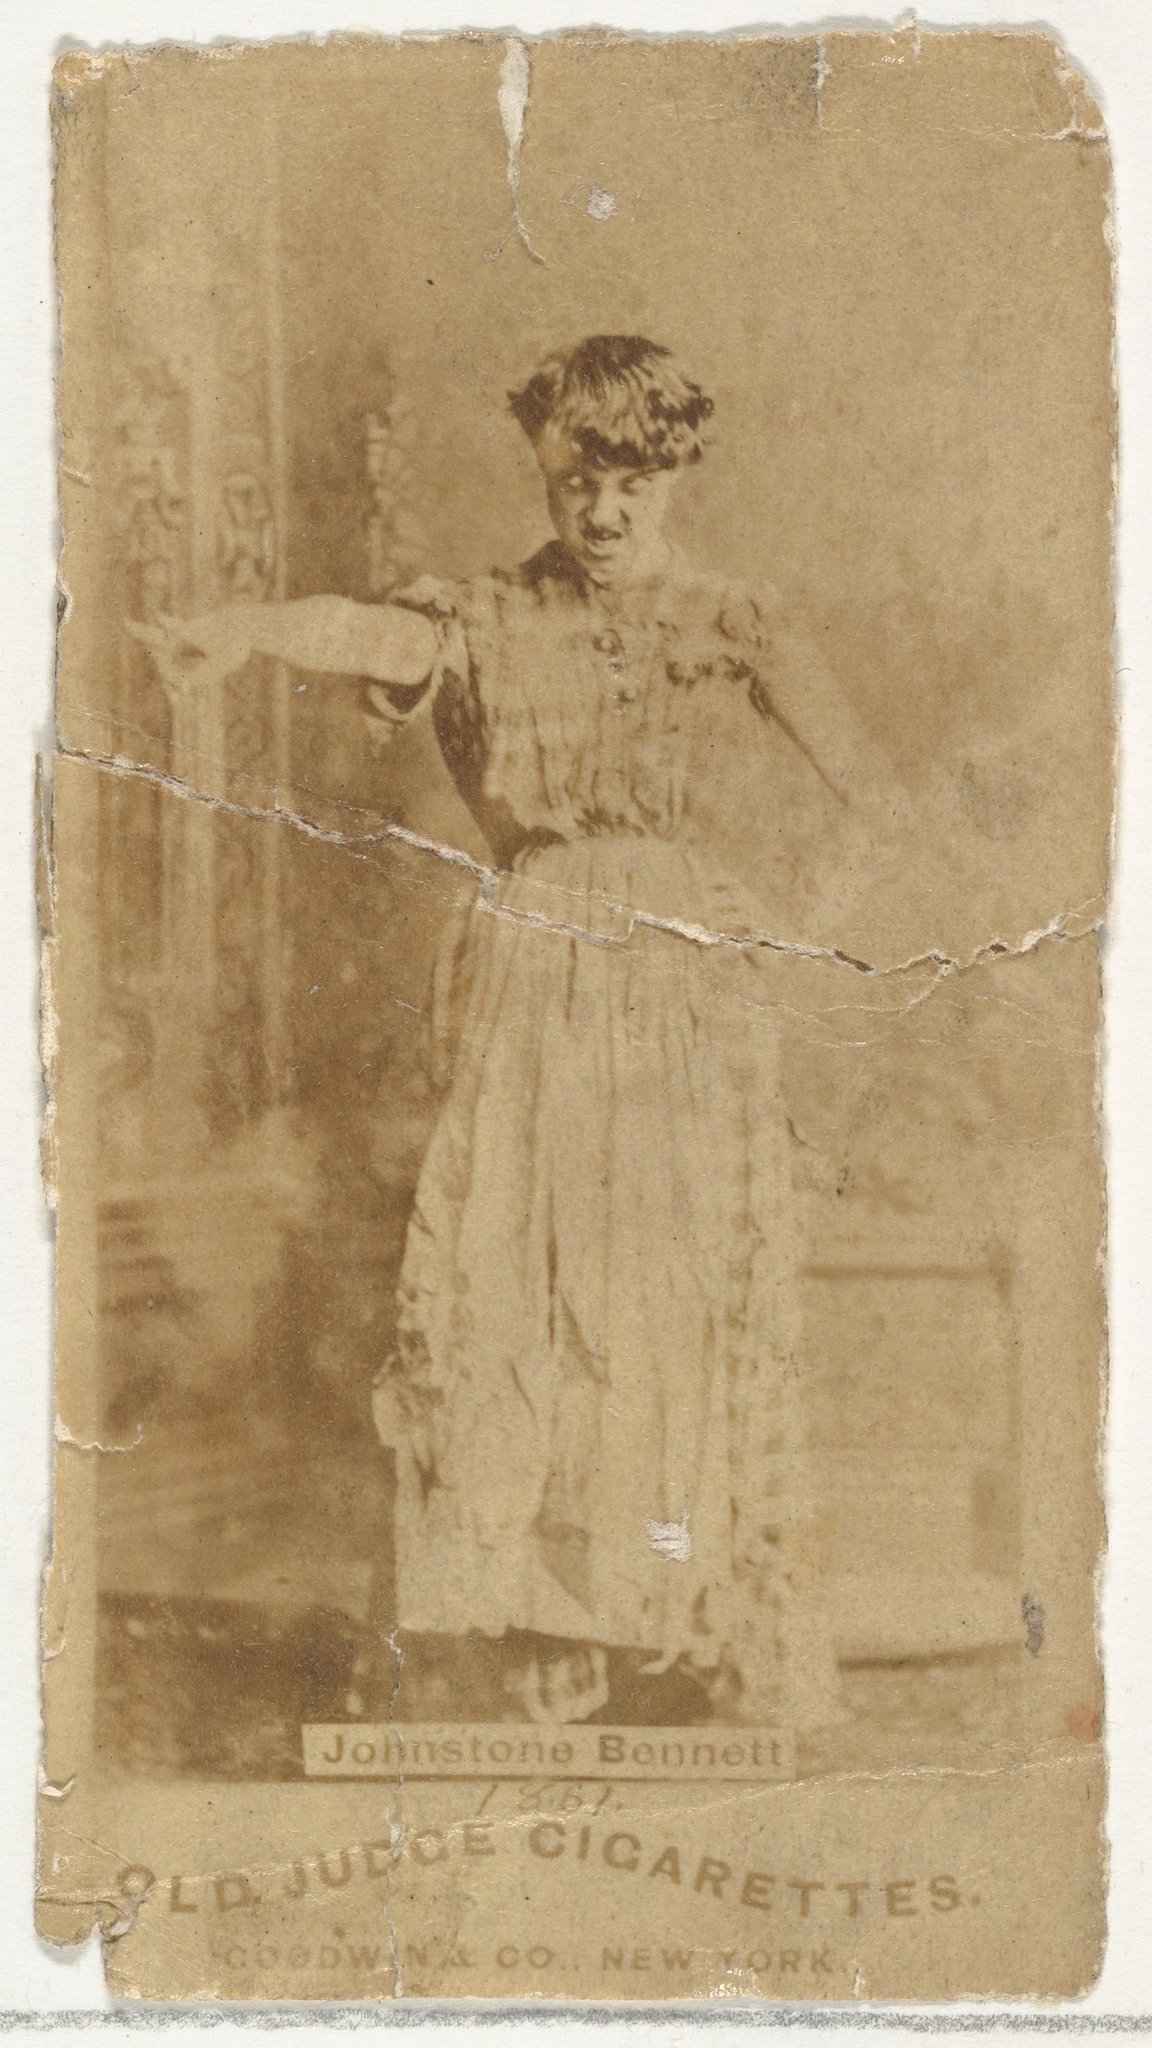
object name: photograph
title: Joanstone Bennett, from the Actors and Actresses series (N171) for Old Judge Cigarettes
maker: goodwin & company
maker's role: publisher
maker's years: 1850-1950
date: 1886-1890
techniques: albumen silver print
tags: portraits,women,actresses